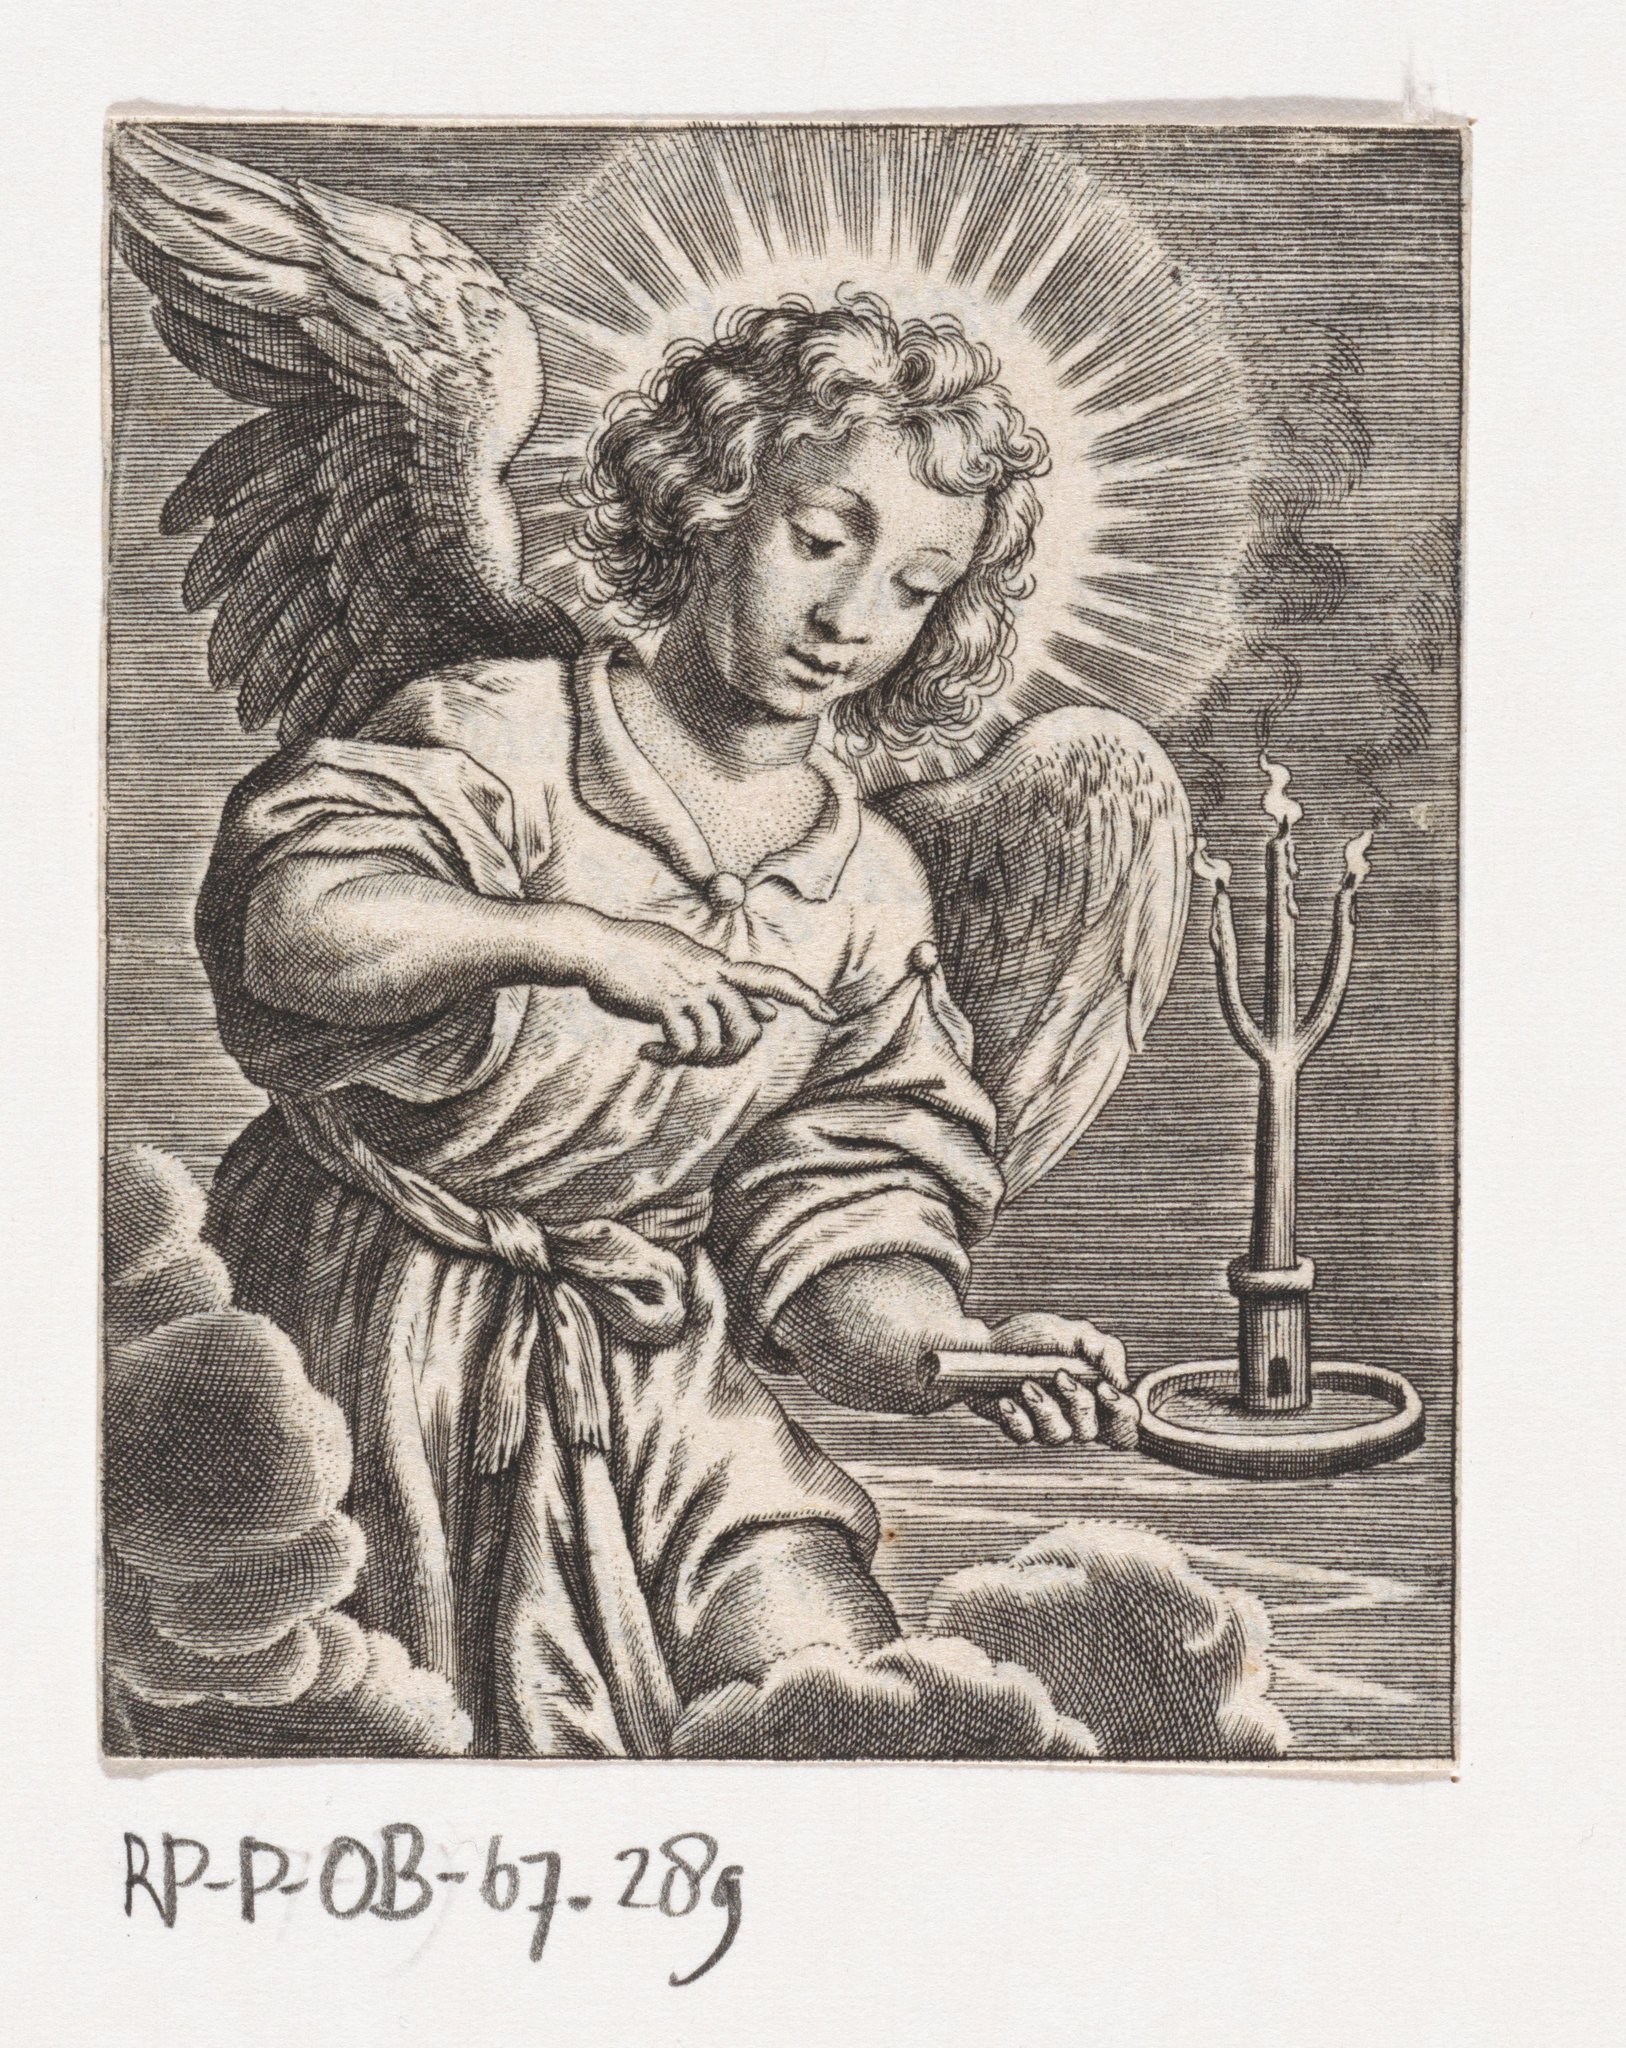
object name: book illustration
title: Engel met kandelaar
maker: wierix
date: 1550-1650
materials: paper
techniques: engraving, letterpress printing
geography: antwerp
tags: candle (+ kindling a light; lit, burning light, lamp, candle), angels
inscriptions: number: ‘38. - 32.’, collector's mark: Lugt 240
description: Een engel houdt een kandelaar, met een torentje, in de hand en wijst op de driearmige brandende kaars.